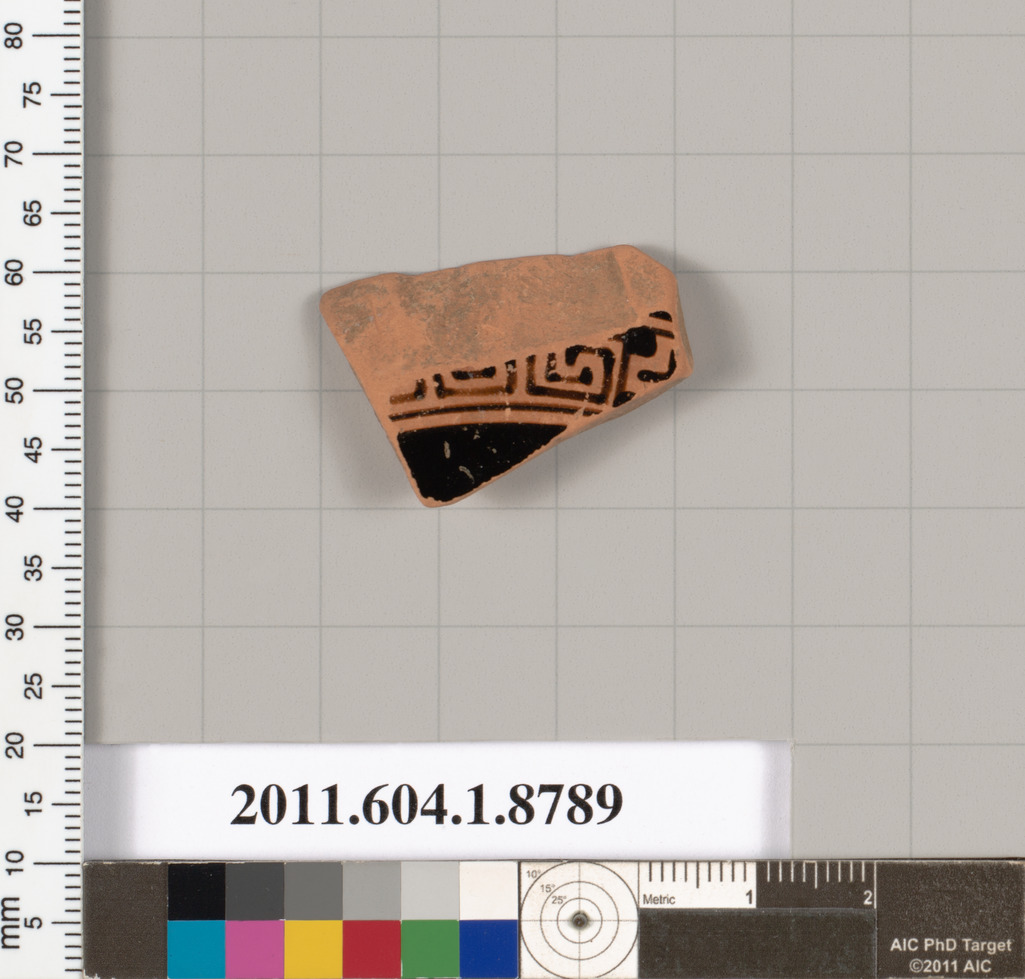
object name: kylix fragment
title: Terracotta fragment of a kylix (drinking cup)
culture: greek, attic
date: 490-480 BCE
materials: terracotta